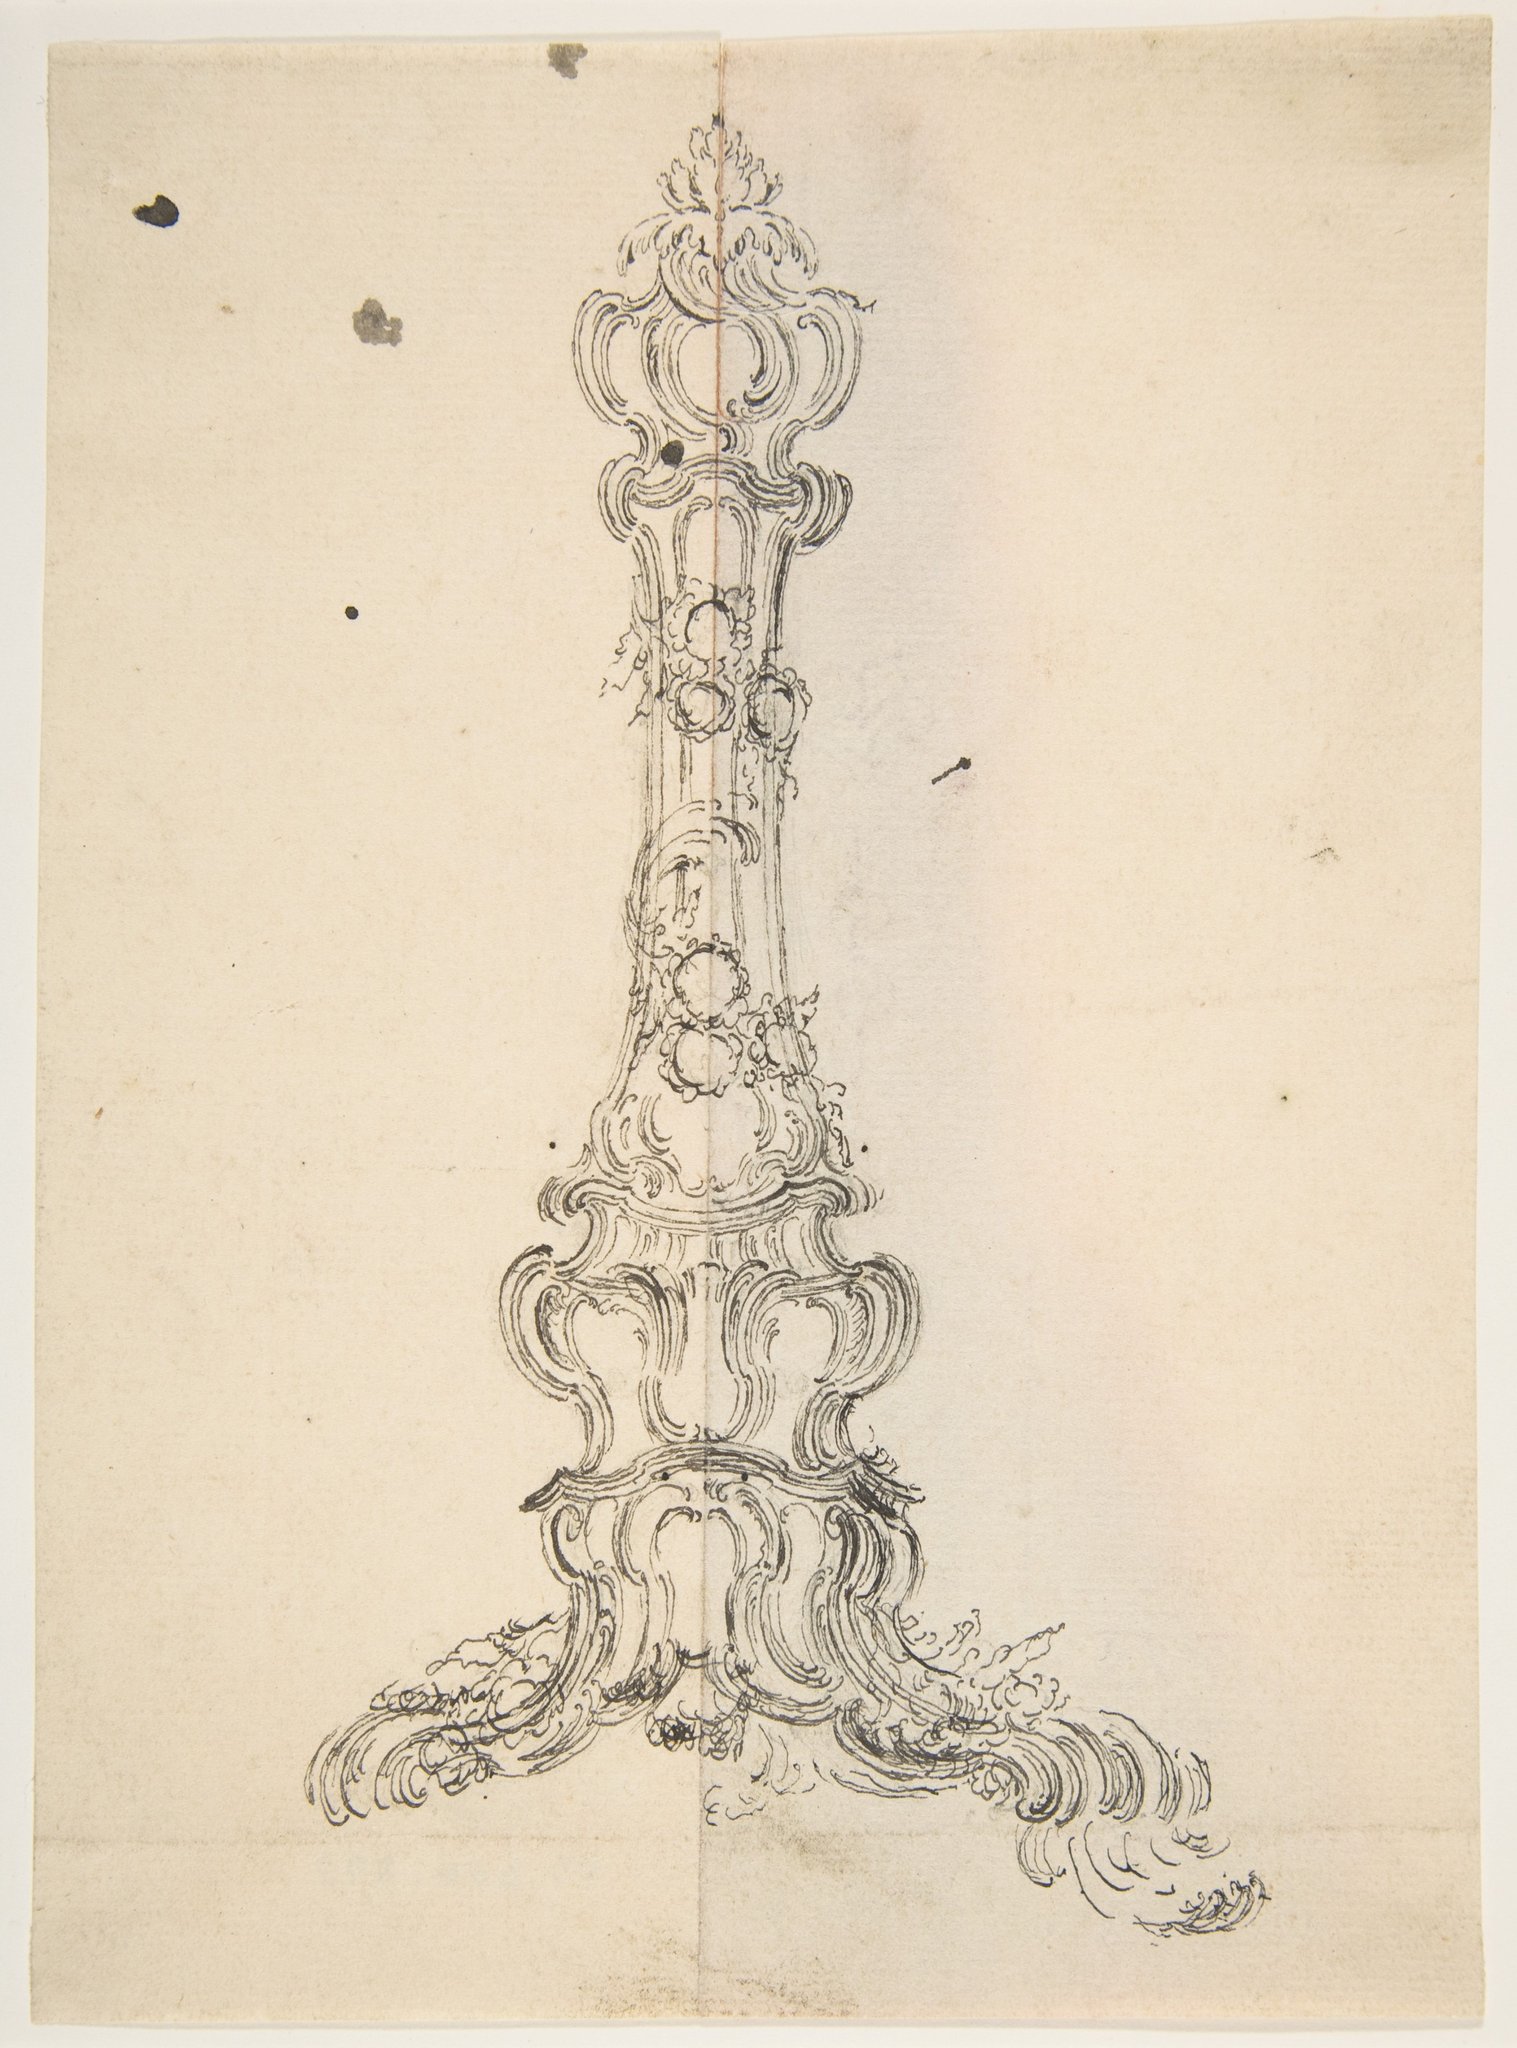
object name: drawing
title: Design for a Candlestick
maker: anonymous, french, 18th century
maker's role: artist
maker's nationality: french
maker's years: 1700-1800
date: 1701-1800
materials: ink, paper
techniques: pen